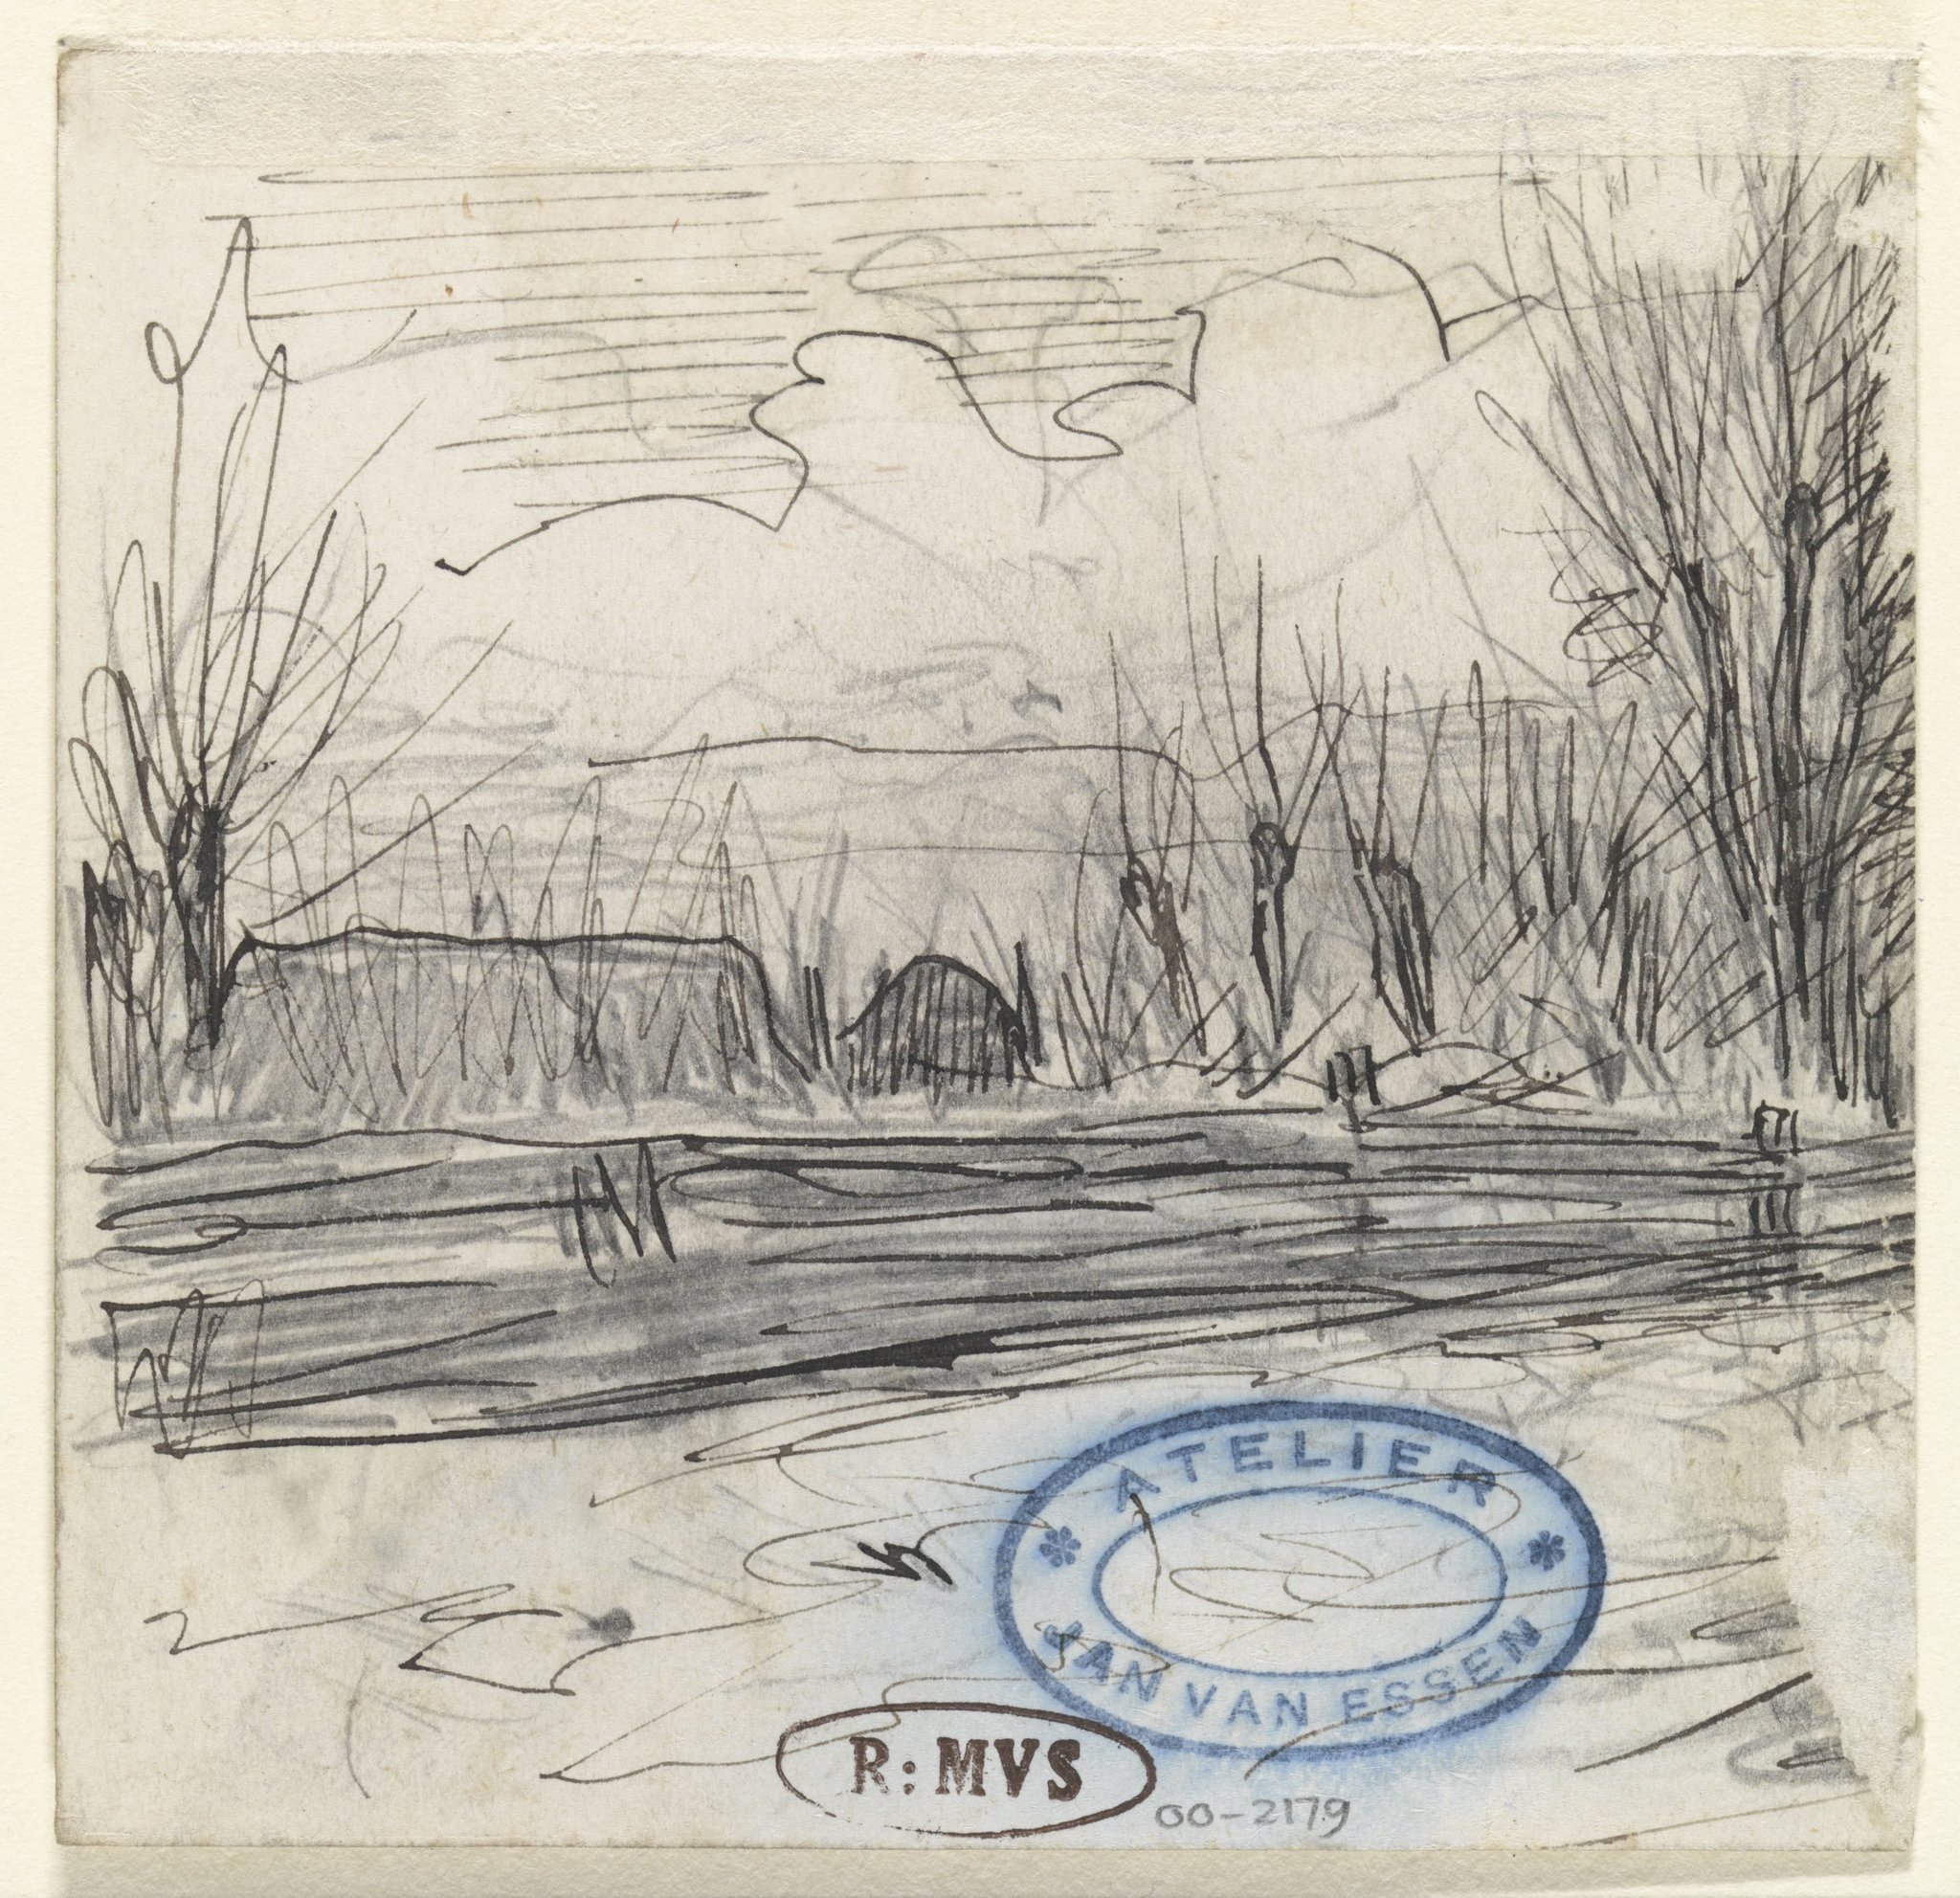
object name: drawing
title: Landschap met huis tussen bomen achter hek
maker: jan van essen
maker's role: draughtsman, print maker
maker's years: 1854-1936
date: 1864-1936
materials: ink, paper, pencil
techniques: pen